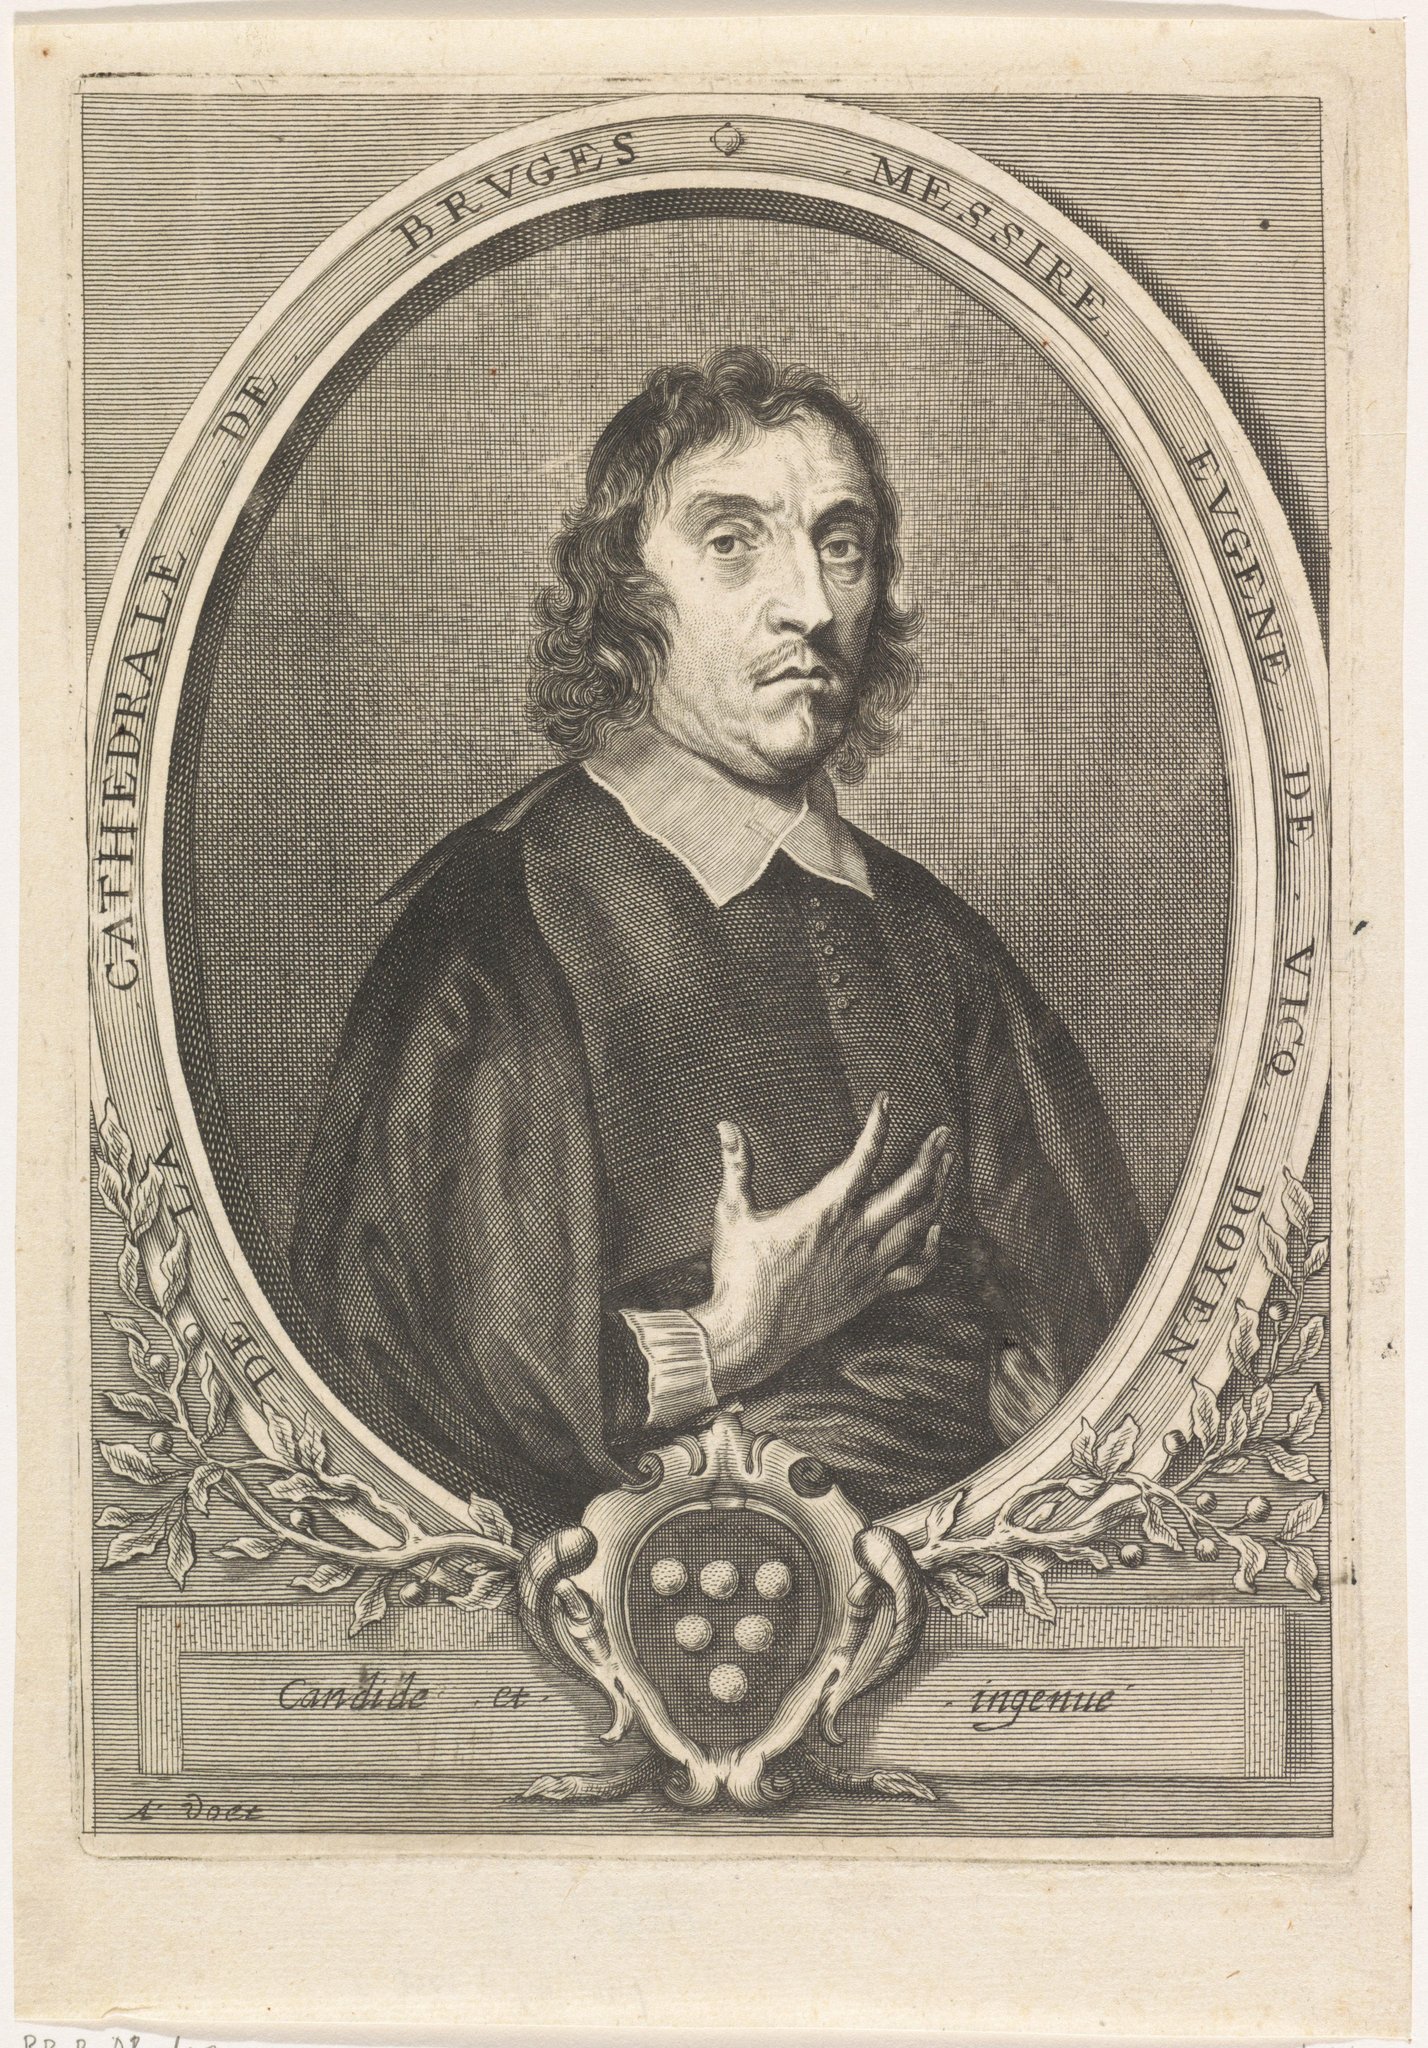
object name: print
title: Portret van Eugene de Vicq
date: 1673-1676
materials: paper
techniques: engraving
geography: antwerp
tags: armorial bearing, heraldry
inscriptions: collector's mark: Lugt 2228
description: Deken van de Sint-Donaaskathedraal in Brugge. Onder het portret zijn familiewapen en zijn motto.